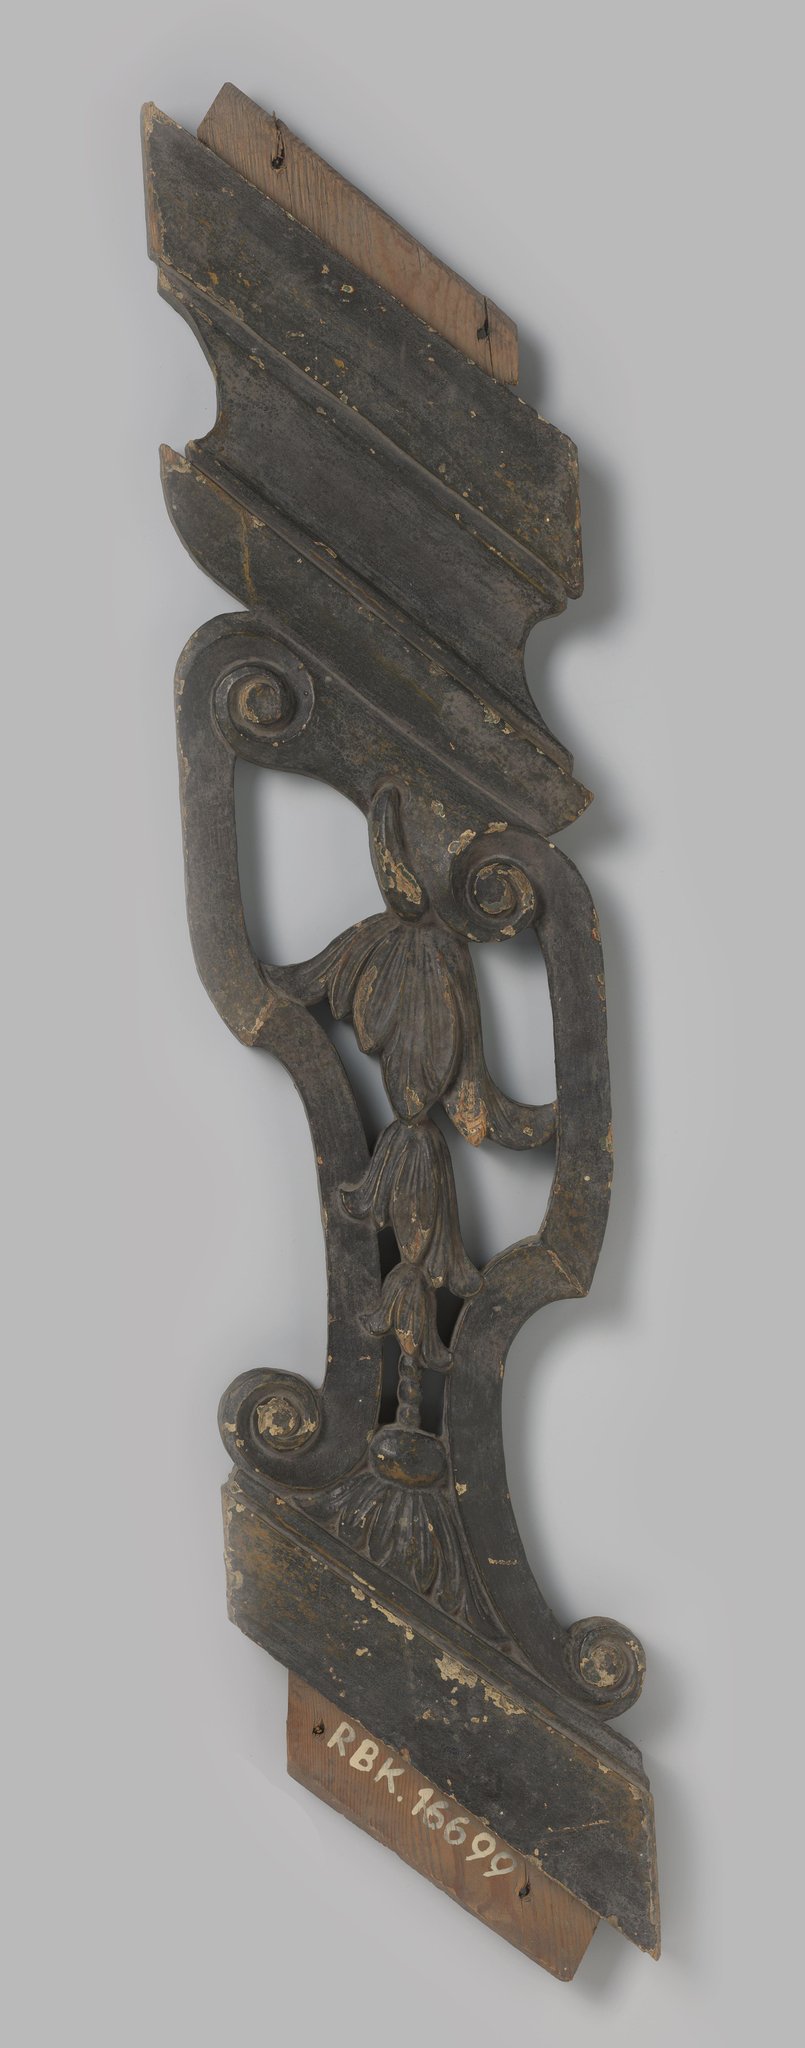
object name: architectural element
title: Bouwfragment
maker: Anonymous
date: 1700-1725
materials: paint, wood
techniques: gilding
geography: netherlands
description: Een houten trapeziumvormige, opengewerkte trapbaluster; in het midden zijn kelken en ter weerszijden zijn toegewende voluten aangebracht.